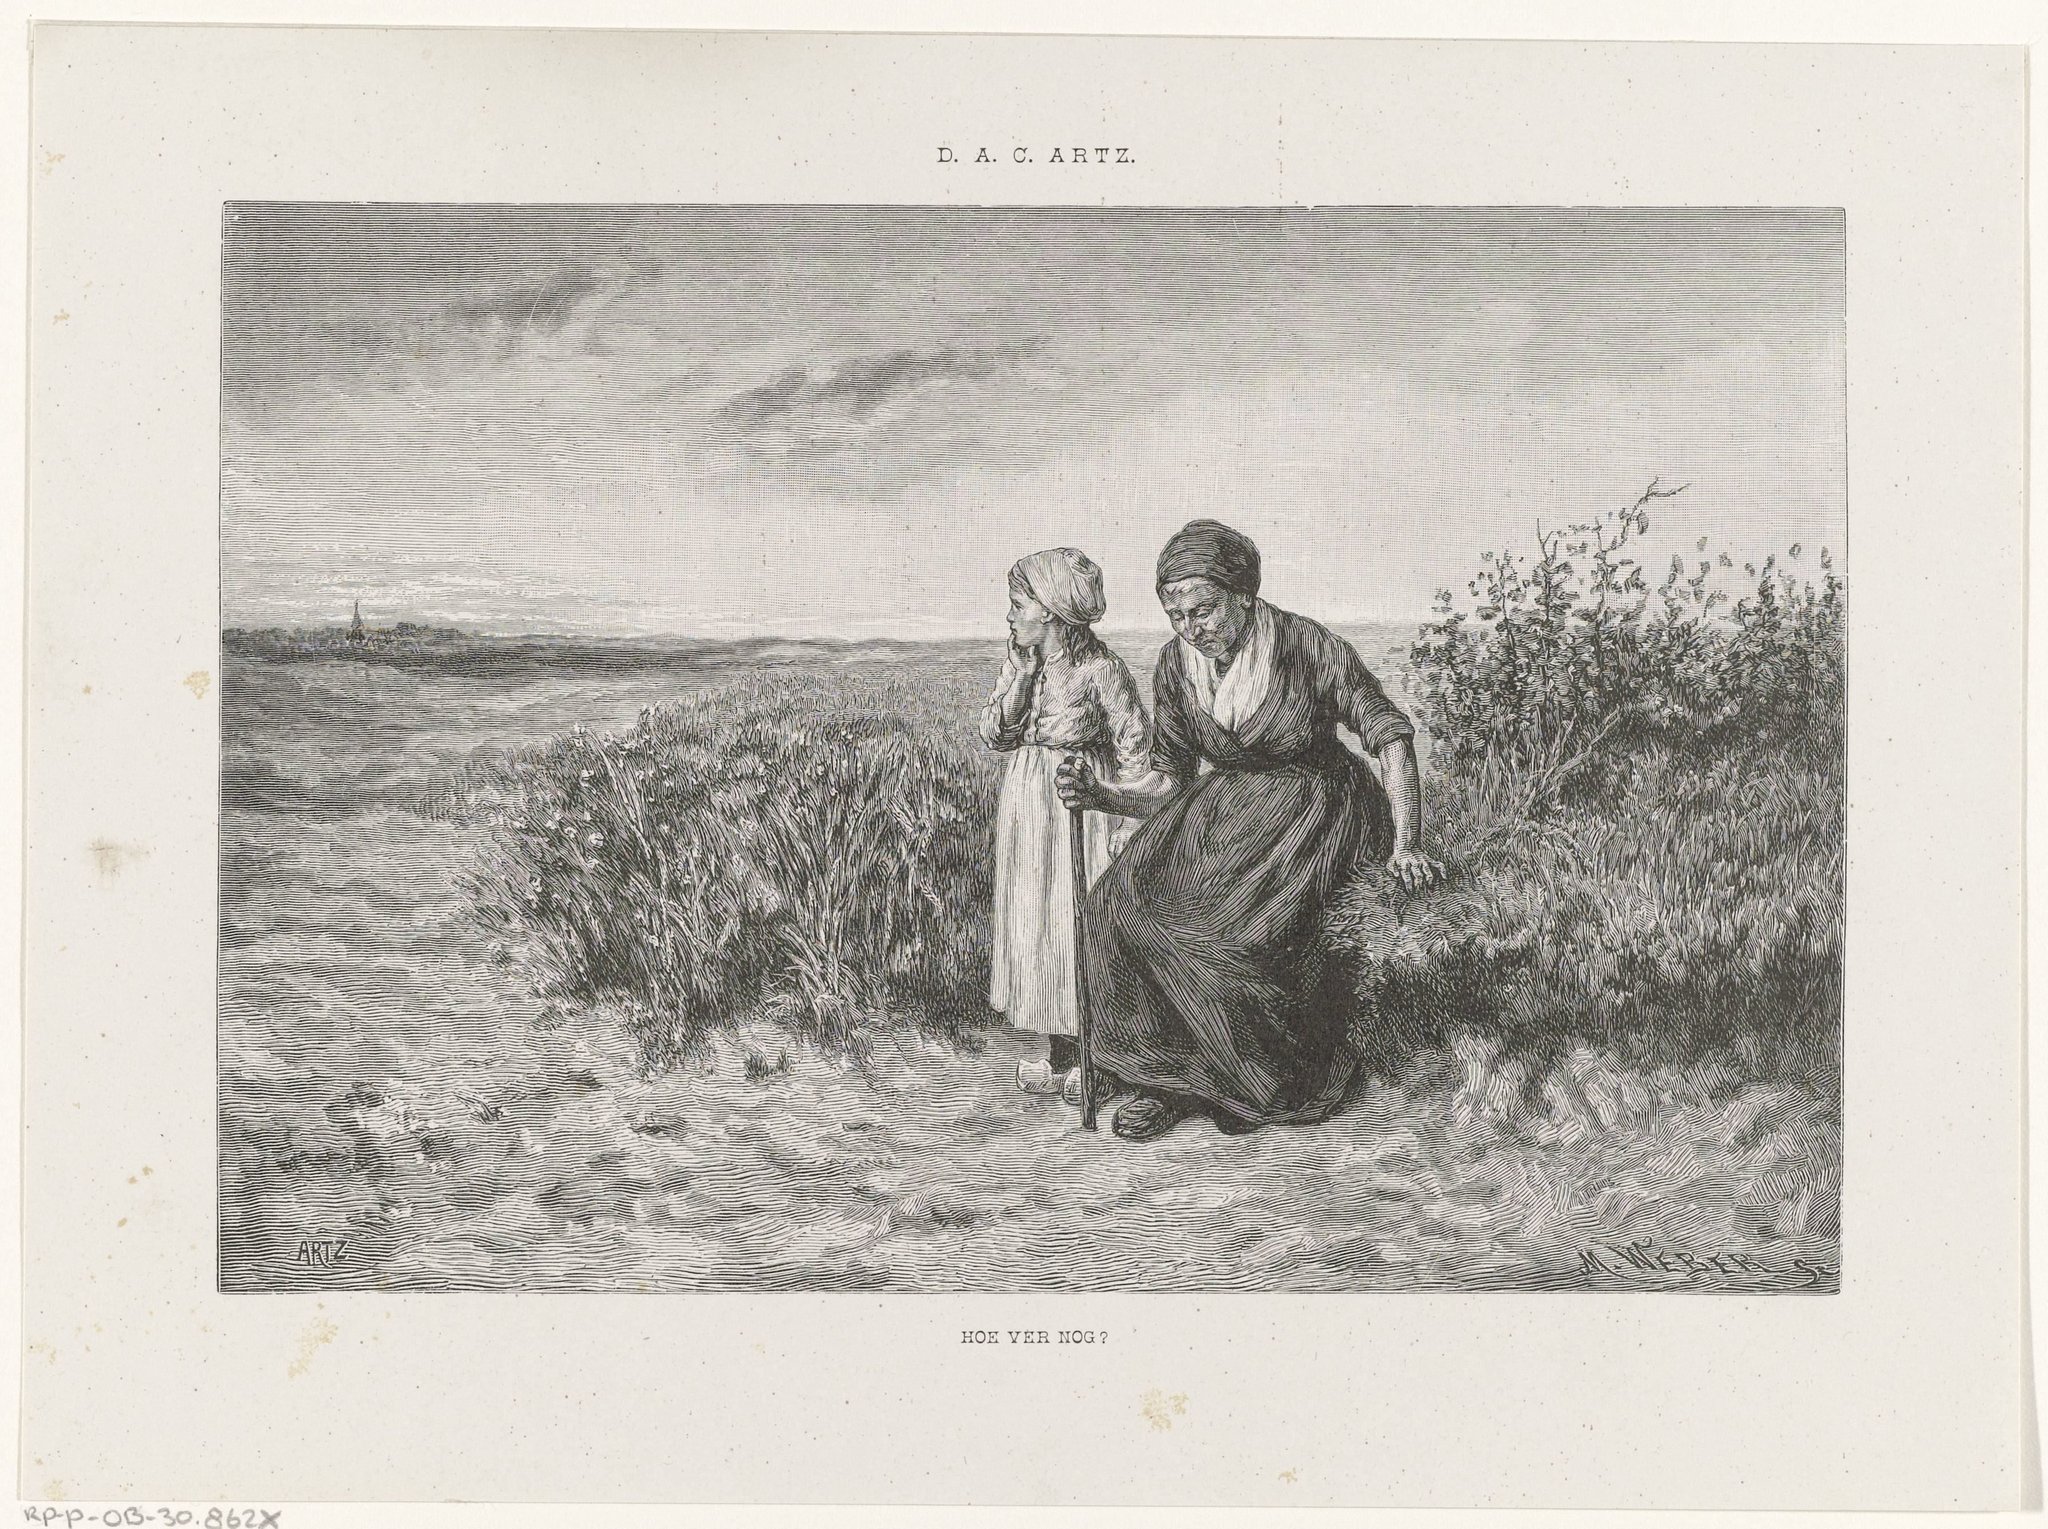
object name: print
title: Hoe ver nog?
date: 1850-1899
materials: paper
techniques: engraving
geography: netherlands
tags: prospect of village, silhouette of village, dunes (sea not visible); in the dunes, resting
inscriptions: collector's mark: Lugt 2228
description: Een vrouw met een stok en een kind rusten in de duinen. Het kind kijkt naar een dorp in de verte.